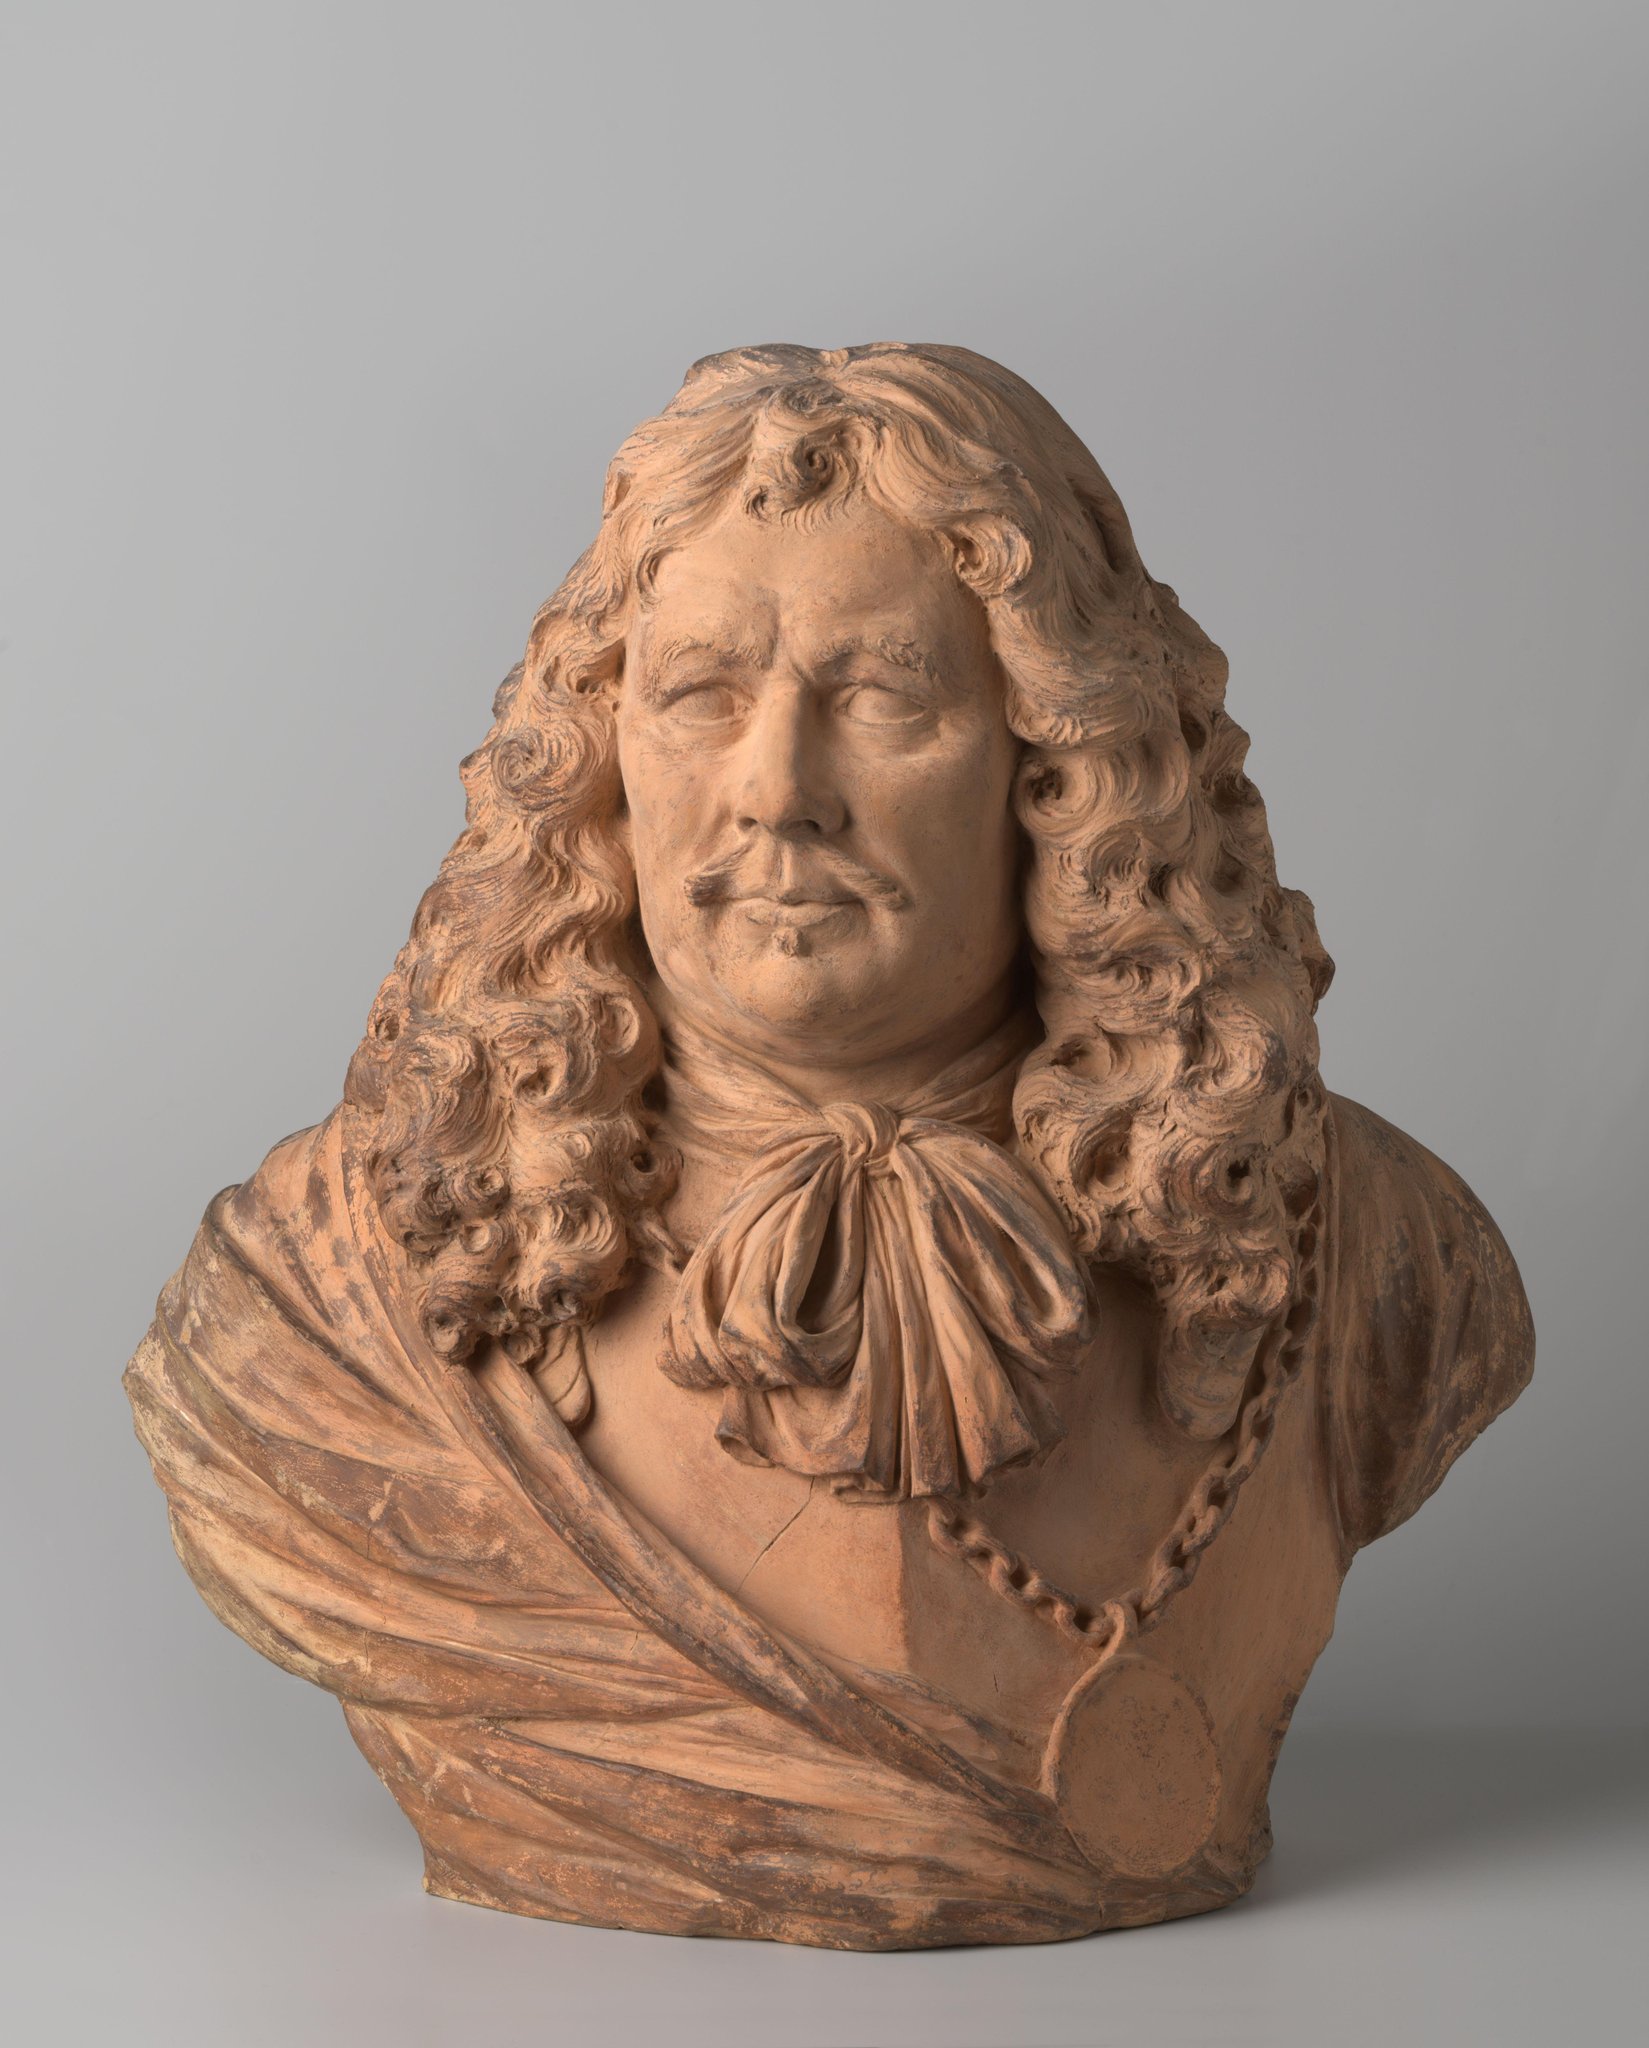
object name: bust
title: Isaac Sweers, Vice Admiral of the Admiralty of Holland and West Friesland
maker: rombout verhulst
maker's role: sculptor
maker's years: 1624-1698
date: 1673-1674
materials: terracotta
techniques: molding, painting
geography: the hague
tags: nijmegen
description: After Vice Admiral Sweers (1622-1673) had been killed in the naval Battle of Kijkduin, he was honoured with a stately tomb. This terracotta bust is the model of the marble portrait for that monument in the Oude Kerk in Amsterdam. Its maker, Rombout Verhulst, left it to Baron Jacob van Wassenaer. The latter ordered the pedestal around 1700, giving rise to a personal tribute to the naval hero.